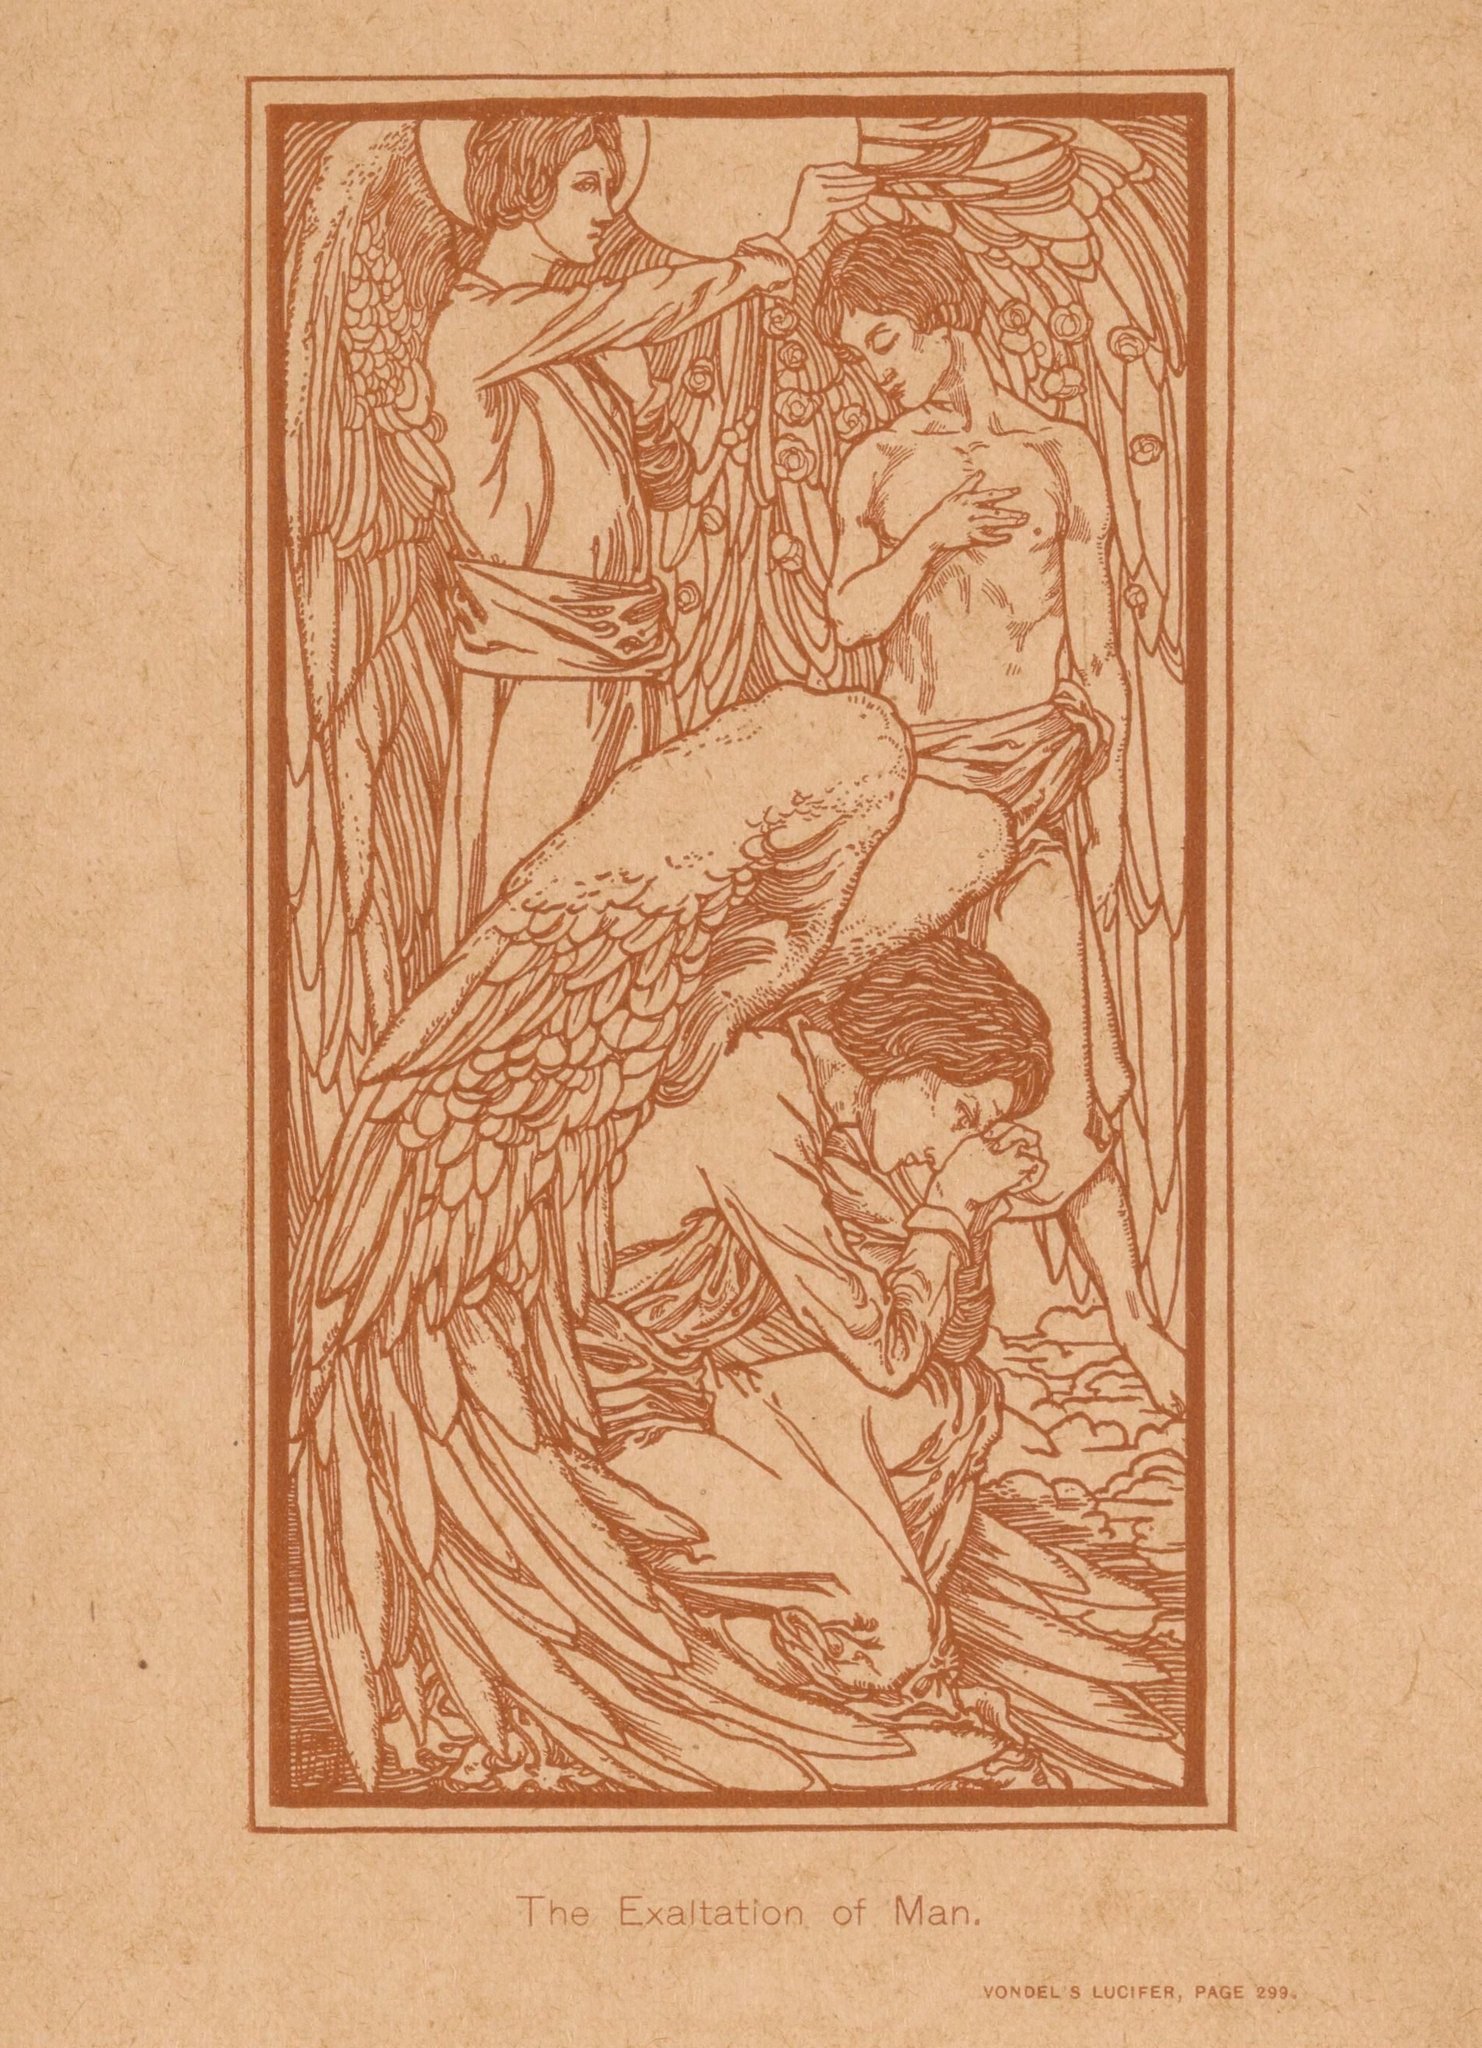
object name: book illustration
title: The Exaltation of Man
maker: johannes josephus aarts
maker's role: draughtsman, print maker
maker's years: 1871-1934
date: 1898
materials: paper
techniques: letterpress printing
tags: nimbus, halo ~ radiance emanating from persons or things, angels, man (showing himself) undressed, quasi-nude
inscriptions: collector's mark: Lugt 2228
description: Prent gebruikt voor: Vondel, Joost van den. Lucifer. [Vertaald uit het Nederlands door] Leonard Charles van Noppen. New York en Londen: Continental Publishing Co., 1898.